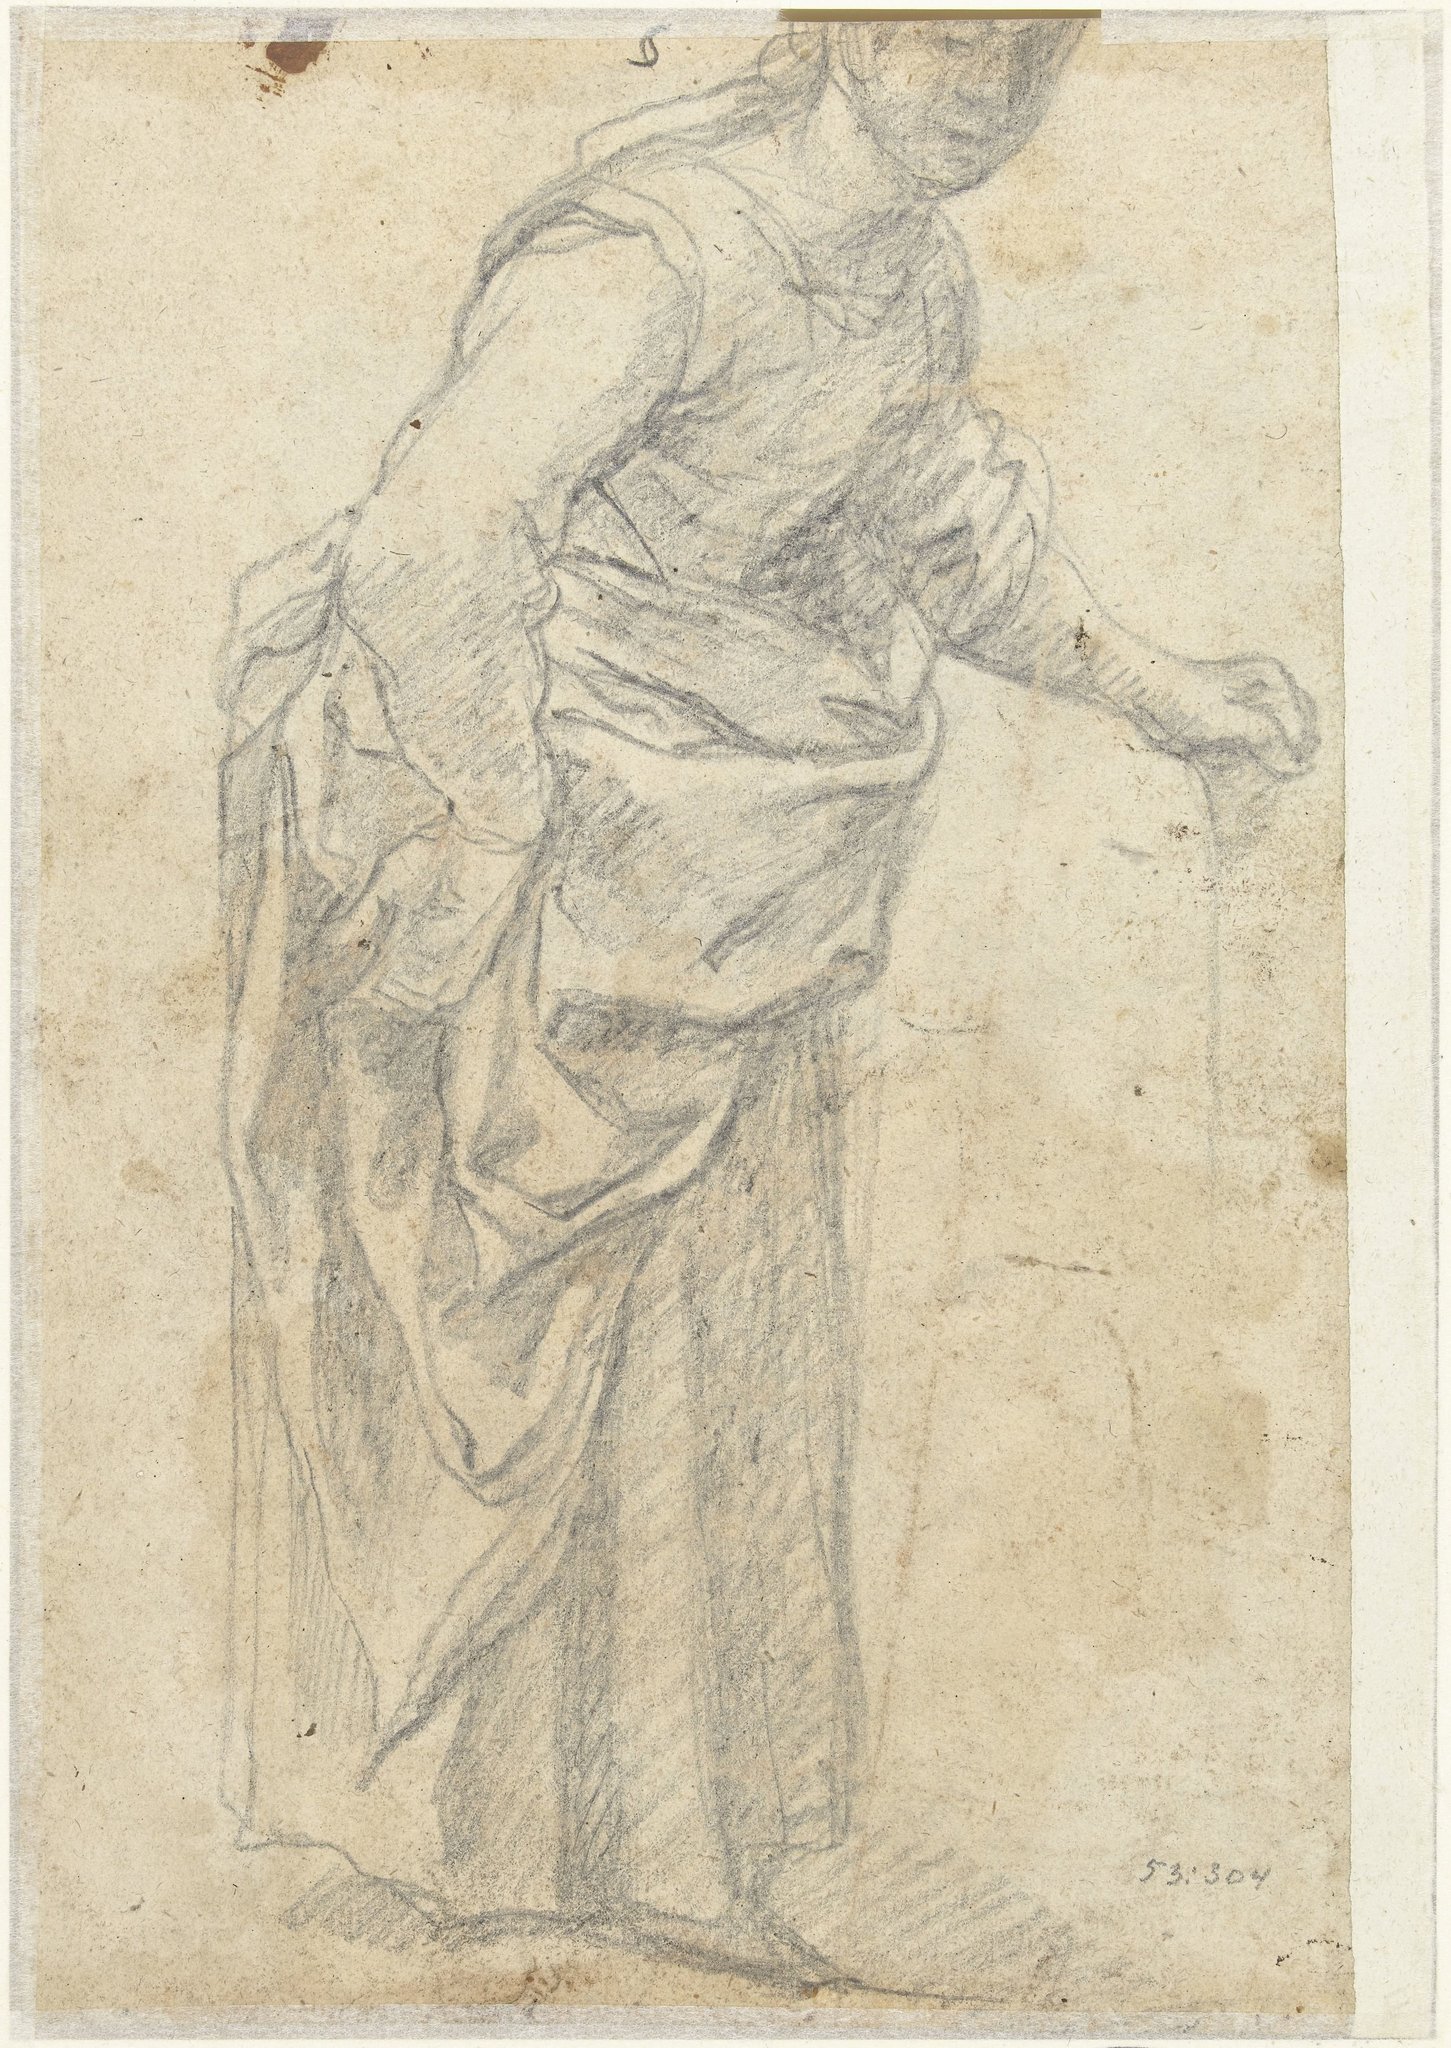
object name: drawing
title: Staande vrouw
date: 1580-1620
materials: graphite, paper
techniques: brush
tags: standing figure - aa - female human figure